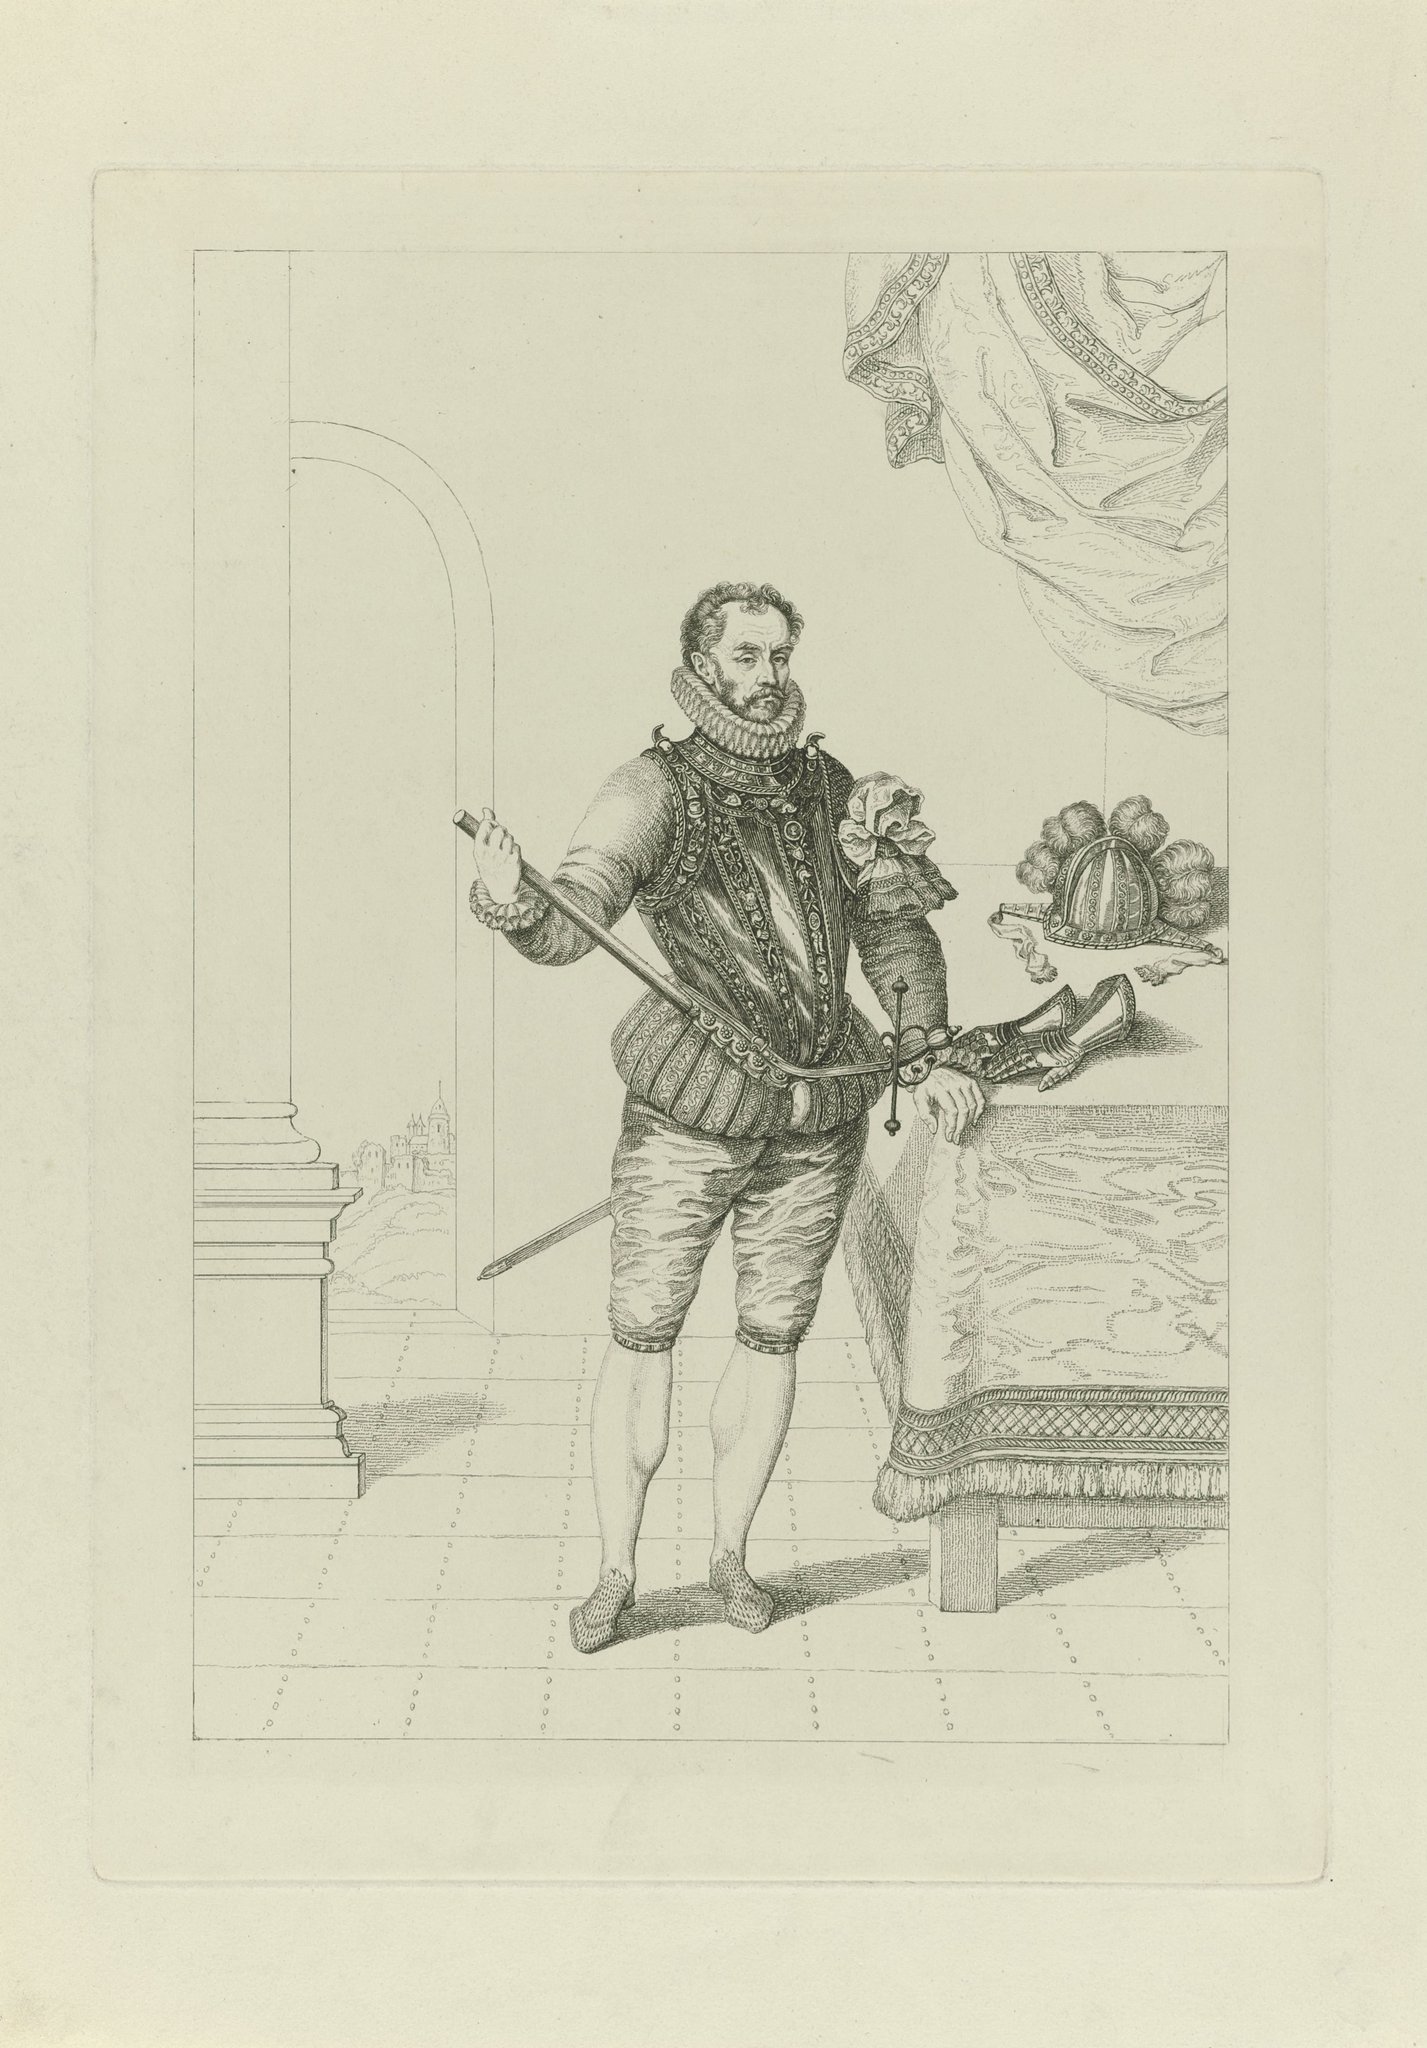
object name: print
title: Portret van Willem I, prins van Oranje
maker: charles turner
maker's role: print maker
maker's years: 1773-1857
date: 1814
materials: paper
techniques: etching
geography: england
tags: delft, william i (prince of orange)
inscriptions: collector's mark: Lugt 963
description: Portret van Willem I. Hij staat in een vertrek naast een tafel, daarop de handschoenen en helm van zijn harnas. Hij houdt een commandostaf in de hand. Op de achtergrond een gezicht op Dillenburg.